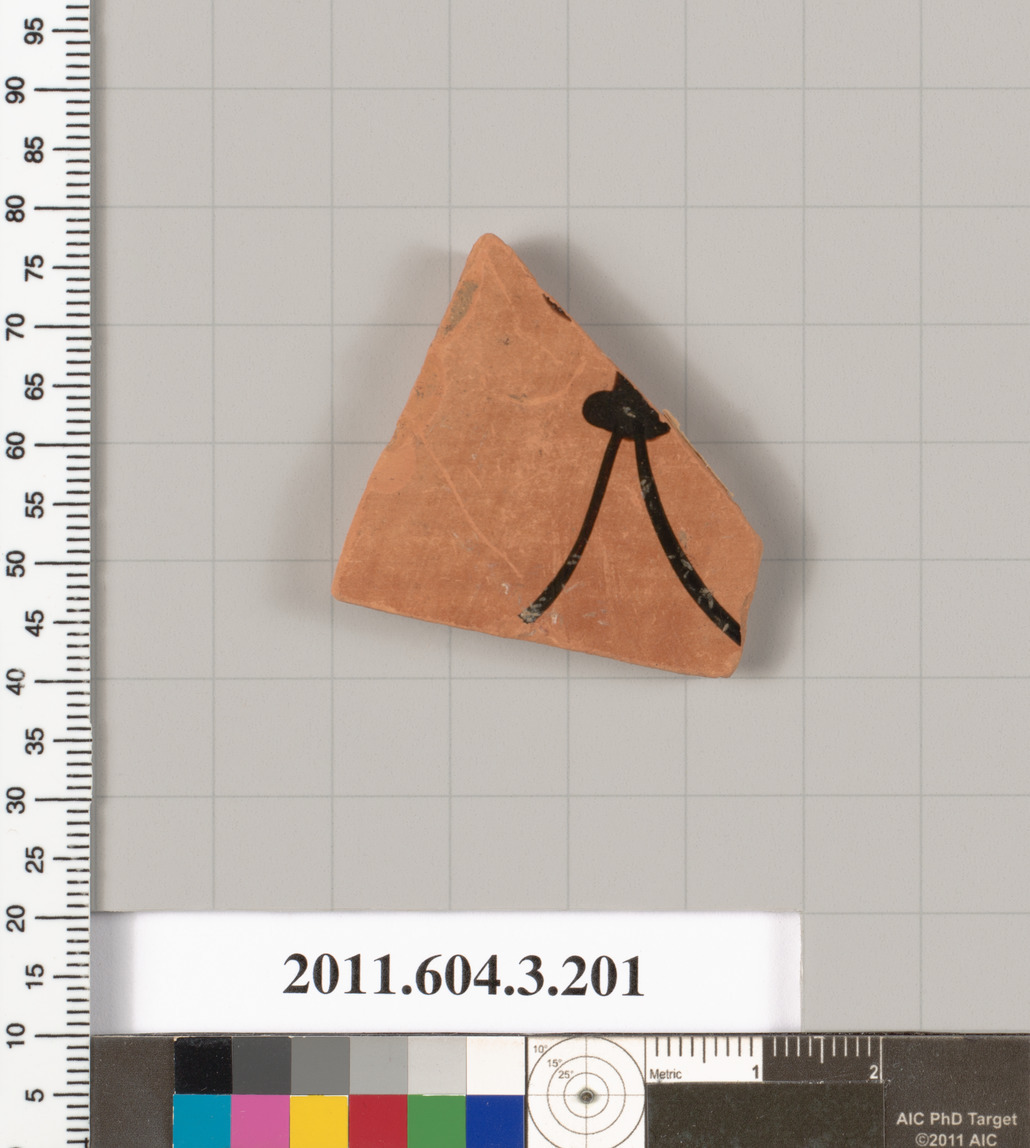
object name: neck amphora fragment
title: Terracotta fragment of a neck-amphora (jar)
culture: greek, attic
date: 530-520 BCE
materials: terracotta